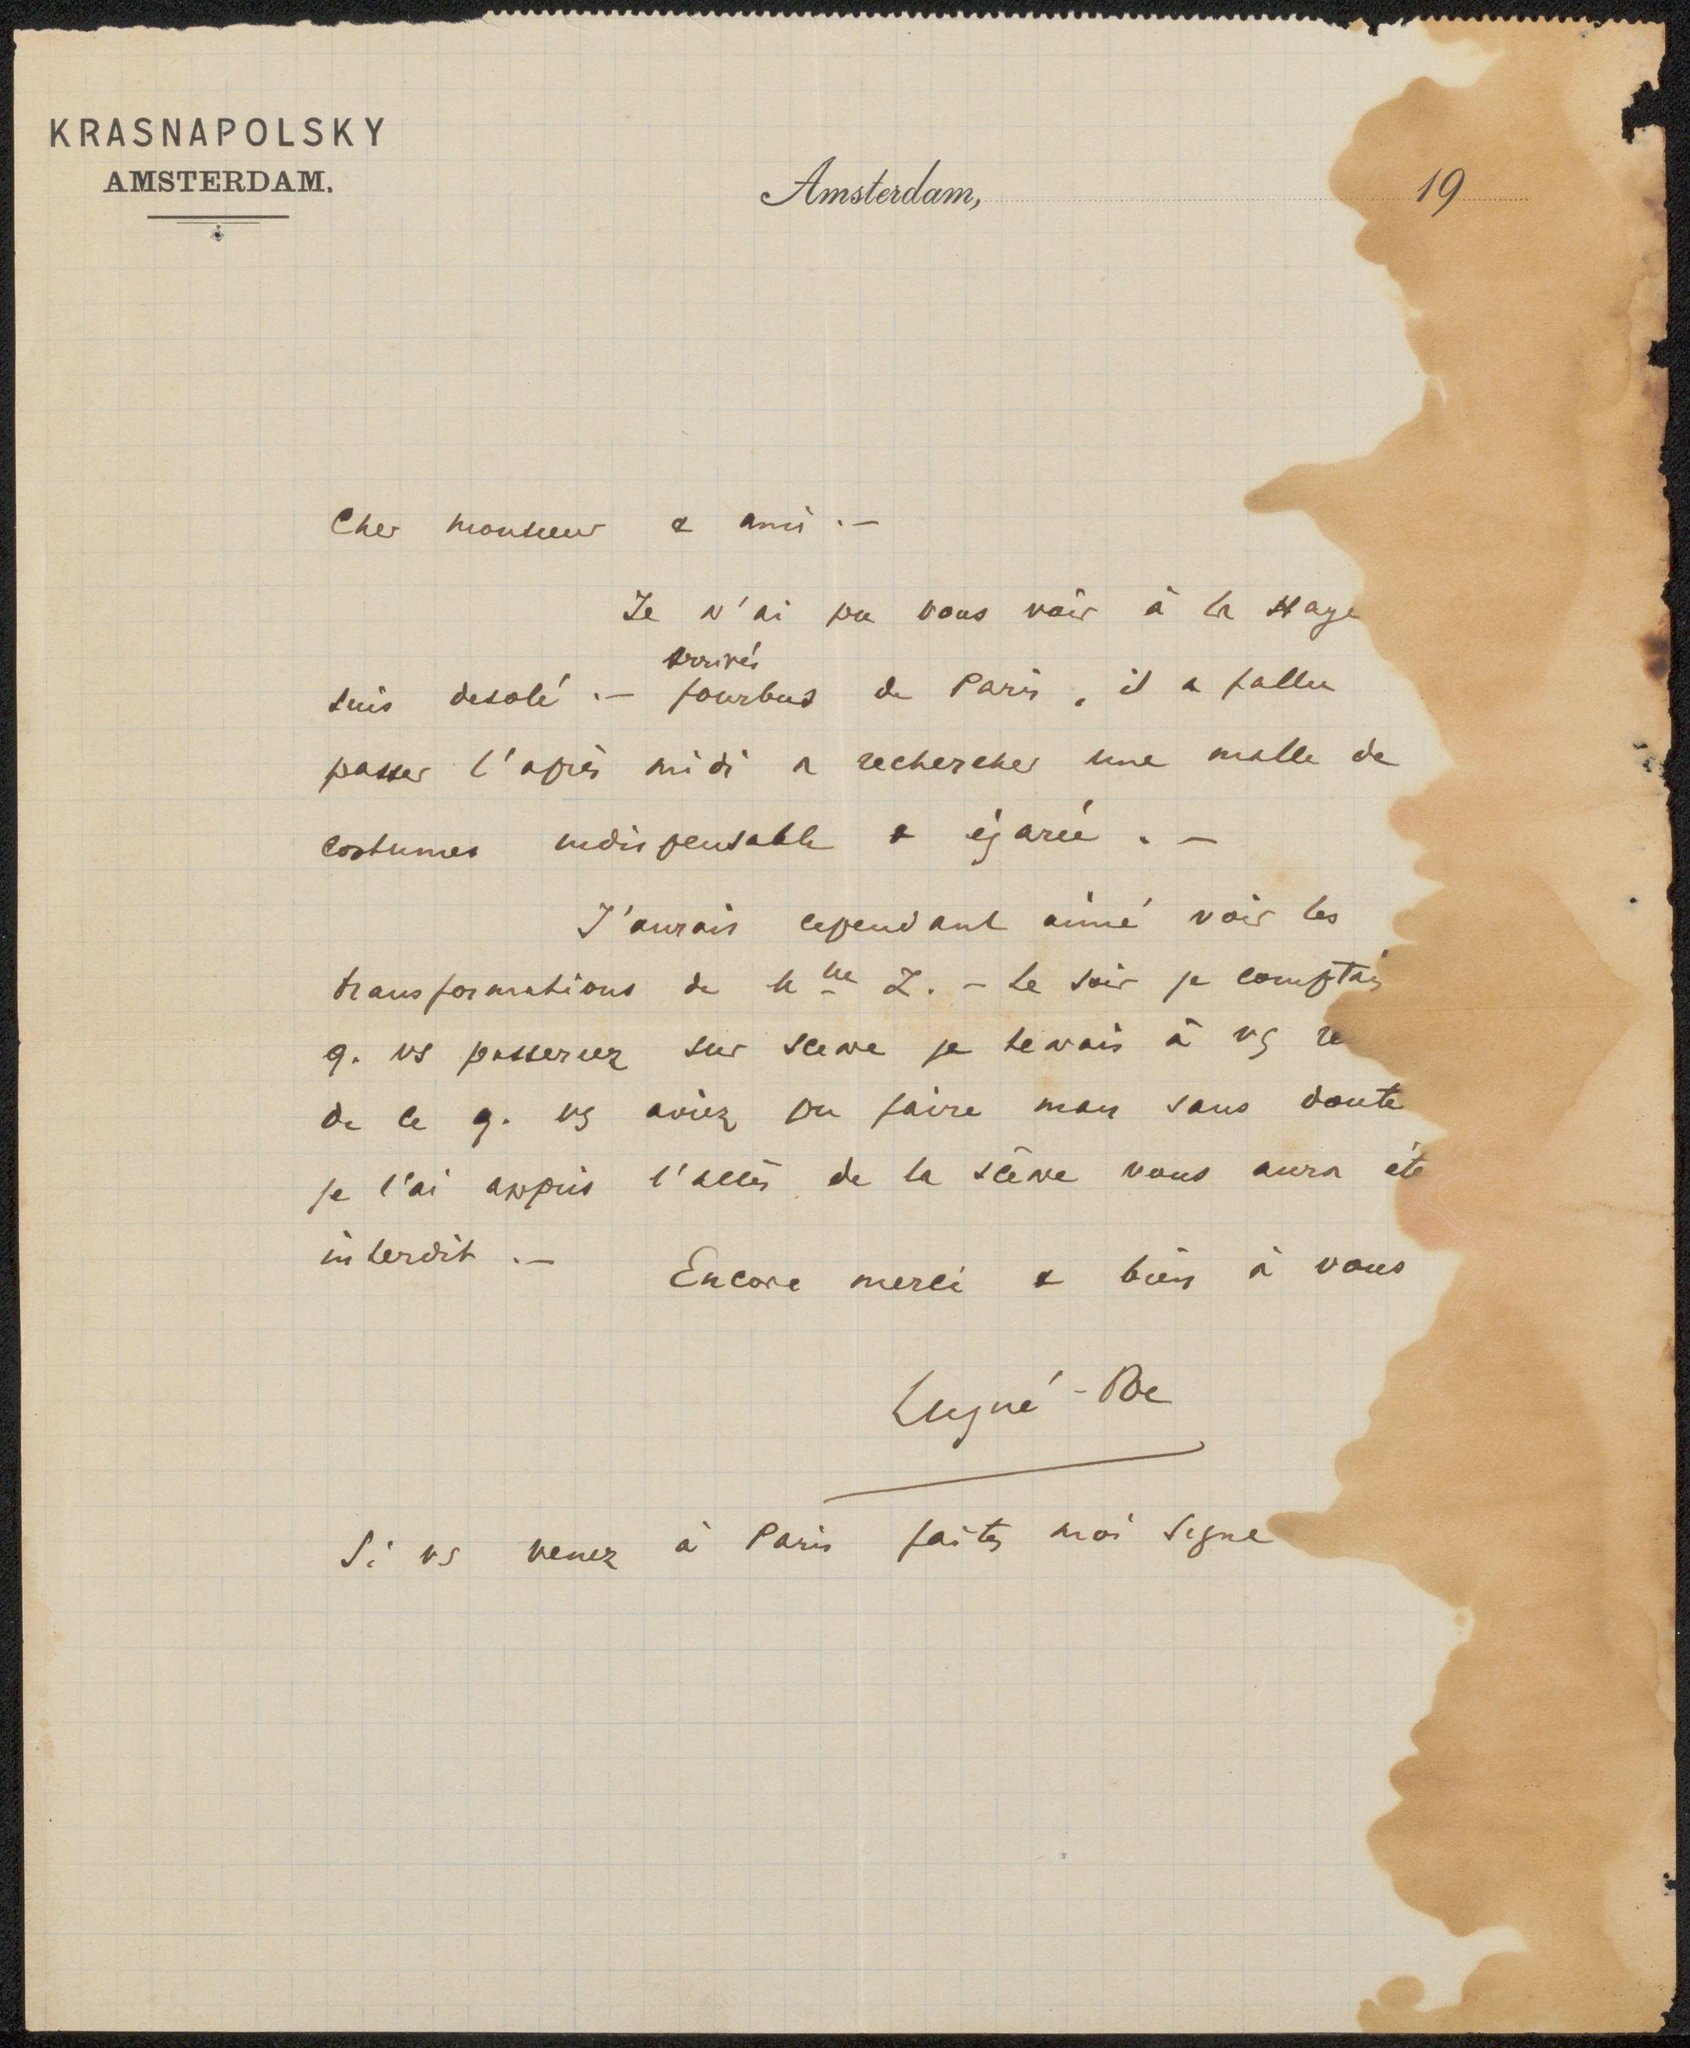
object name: letter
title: Brief aan Philip Zilcken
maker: lugné-poe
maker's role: acteur, theaterdirecteur, theatervormgever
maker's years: 1869-1940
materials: ink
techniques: pen, printing, writing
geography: amsterdam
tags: the hague, painter, draughtsman, philip zilcken, paris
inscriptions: collector's mark: ‘RPK’